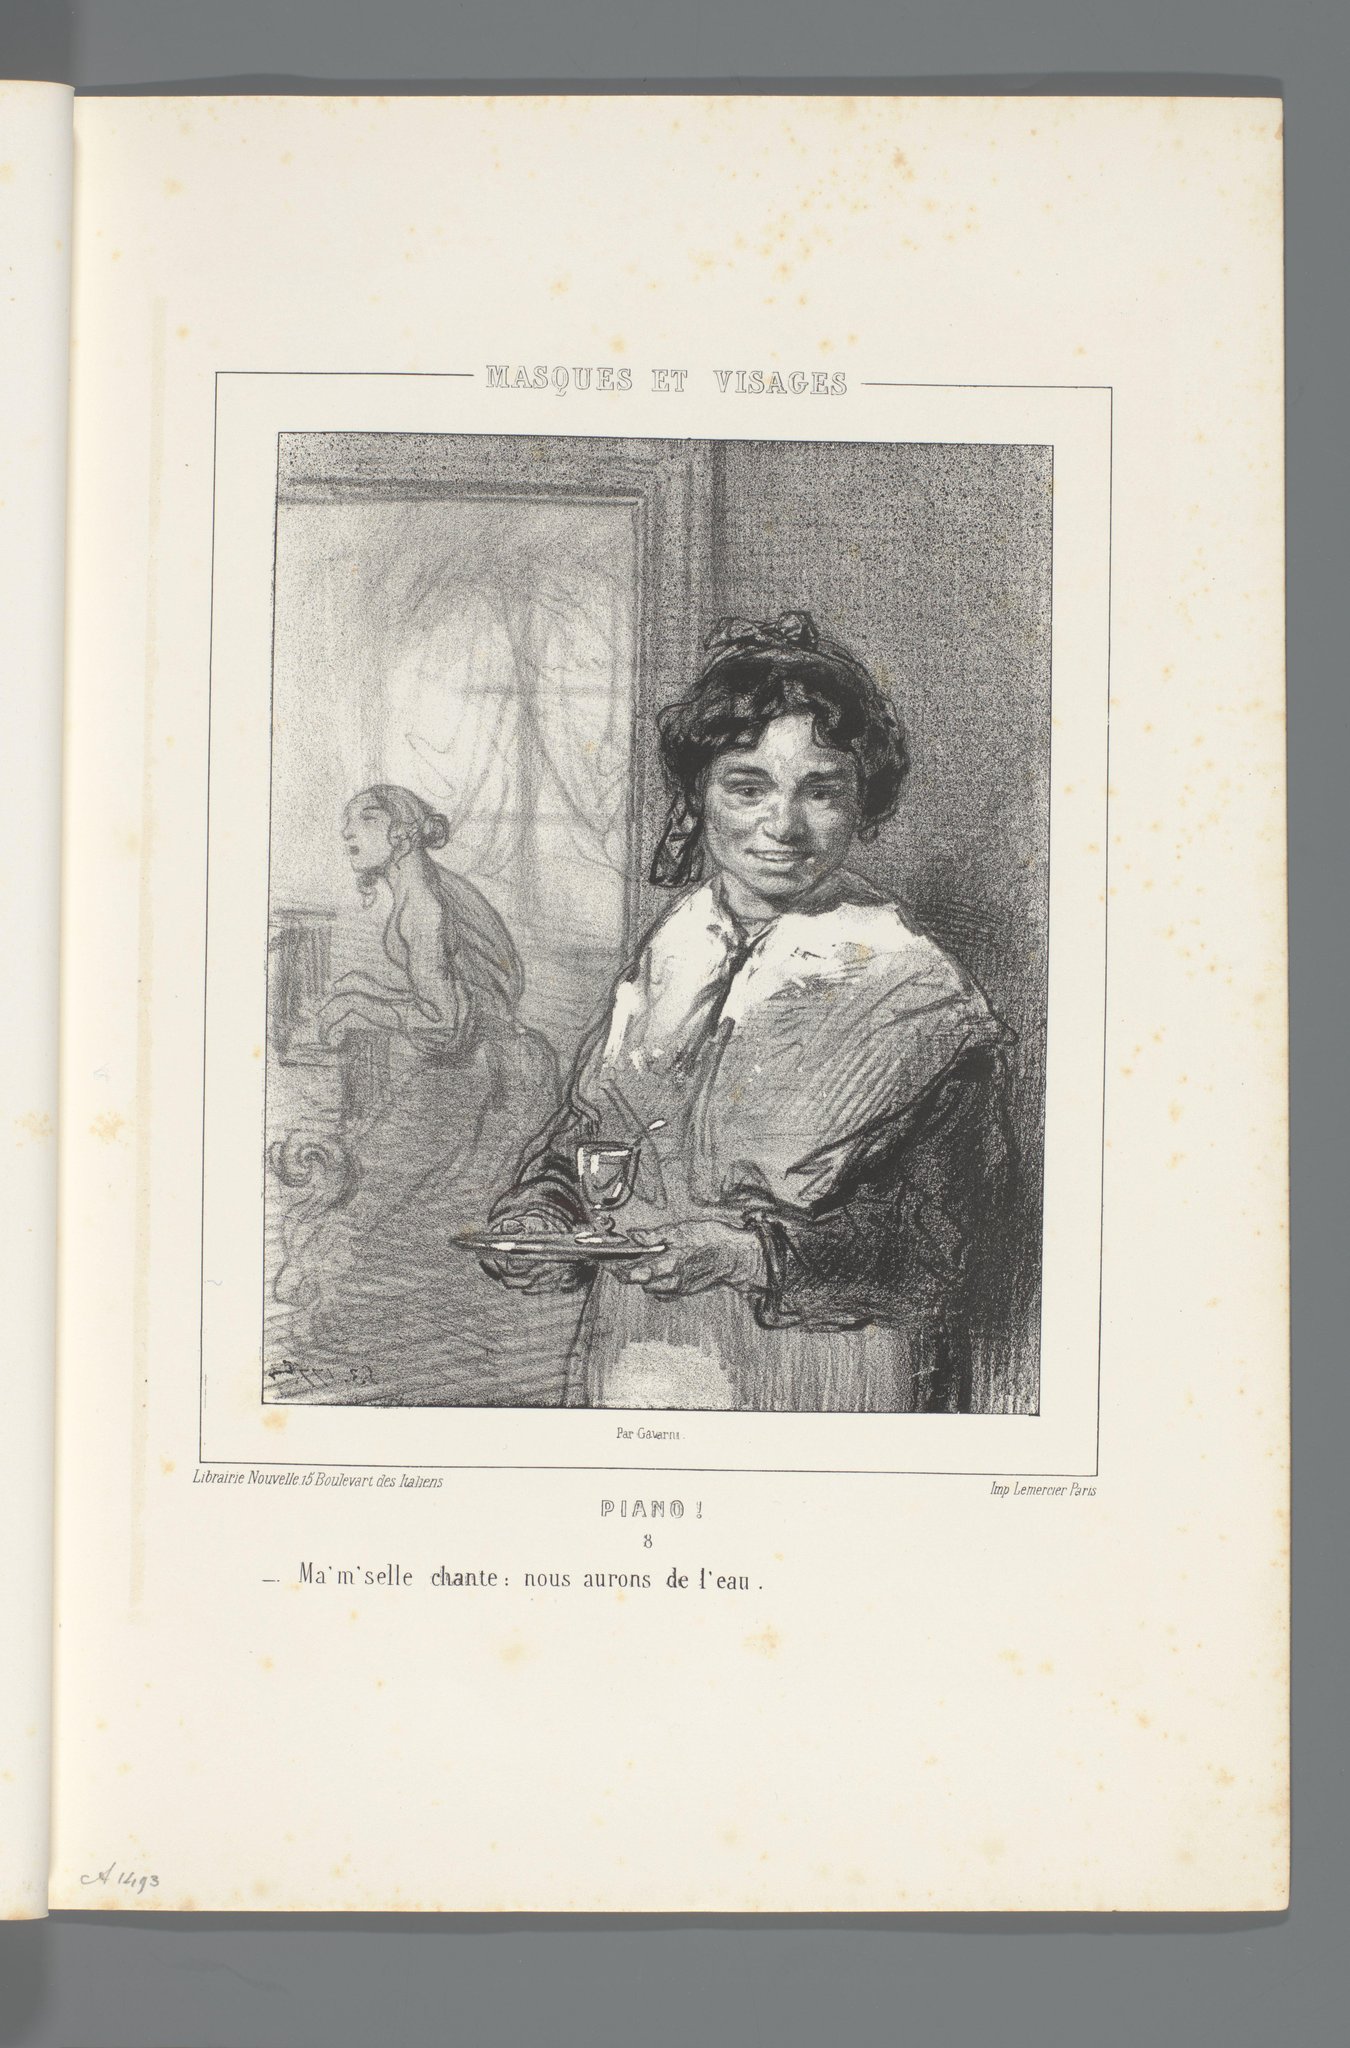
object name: album leaf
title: Masques et Visages. Piano!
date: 1853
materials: paper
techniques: lithograph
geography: paris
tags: maid ~ house personnel, singer accompanying himself, pianoforte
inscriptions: collector's mark: Lugt 964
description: Prent gebruikt voor: Paris (journal), 221 november 1853.